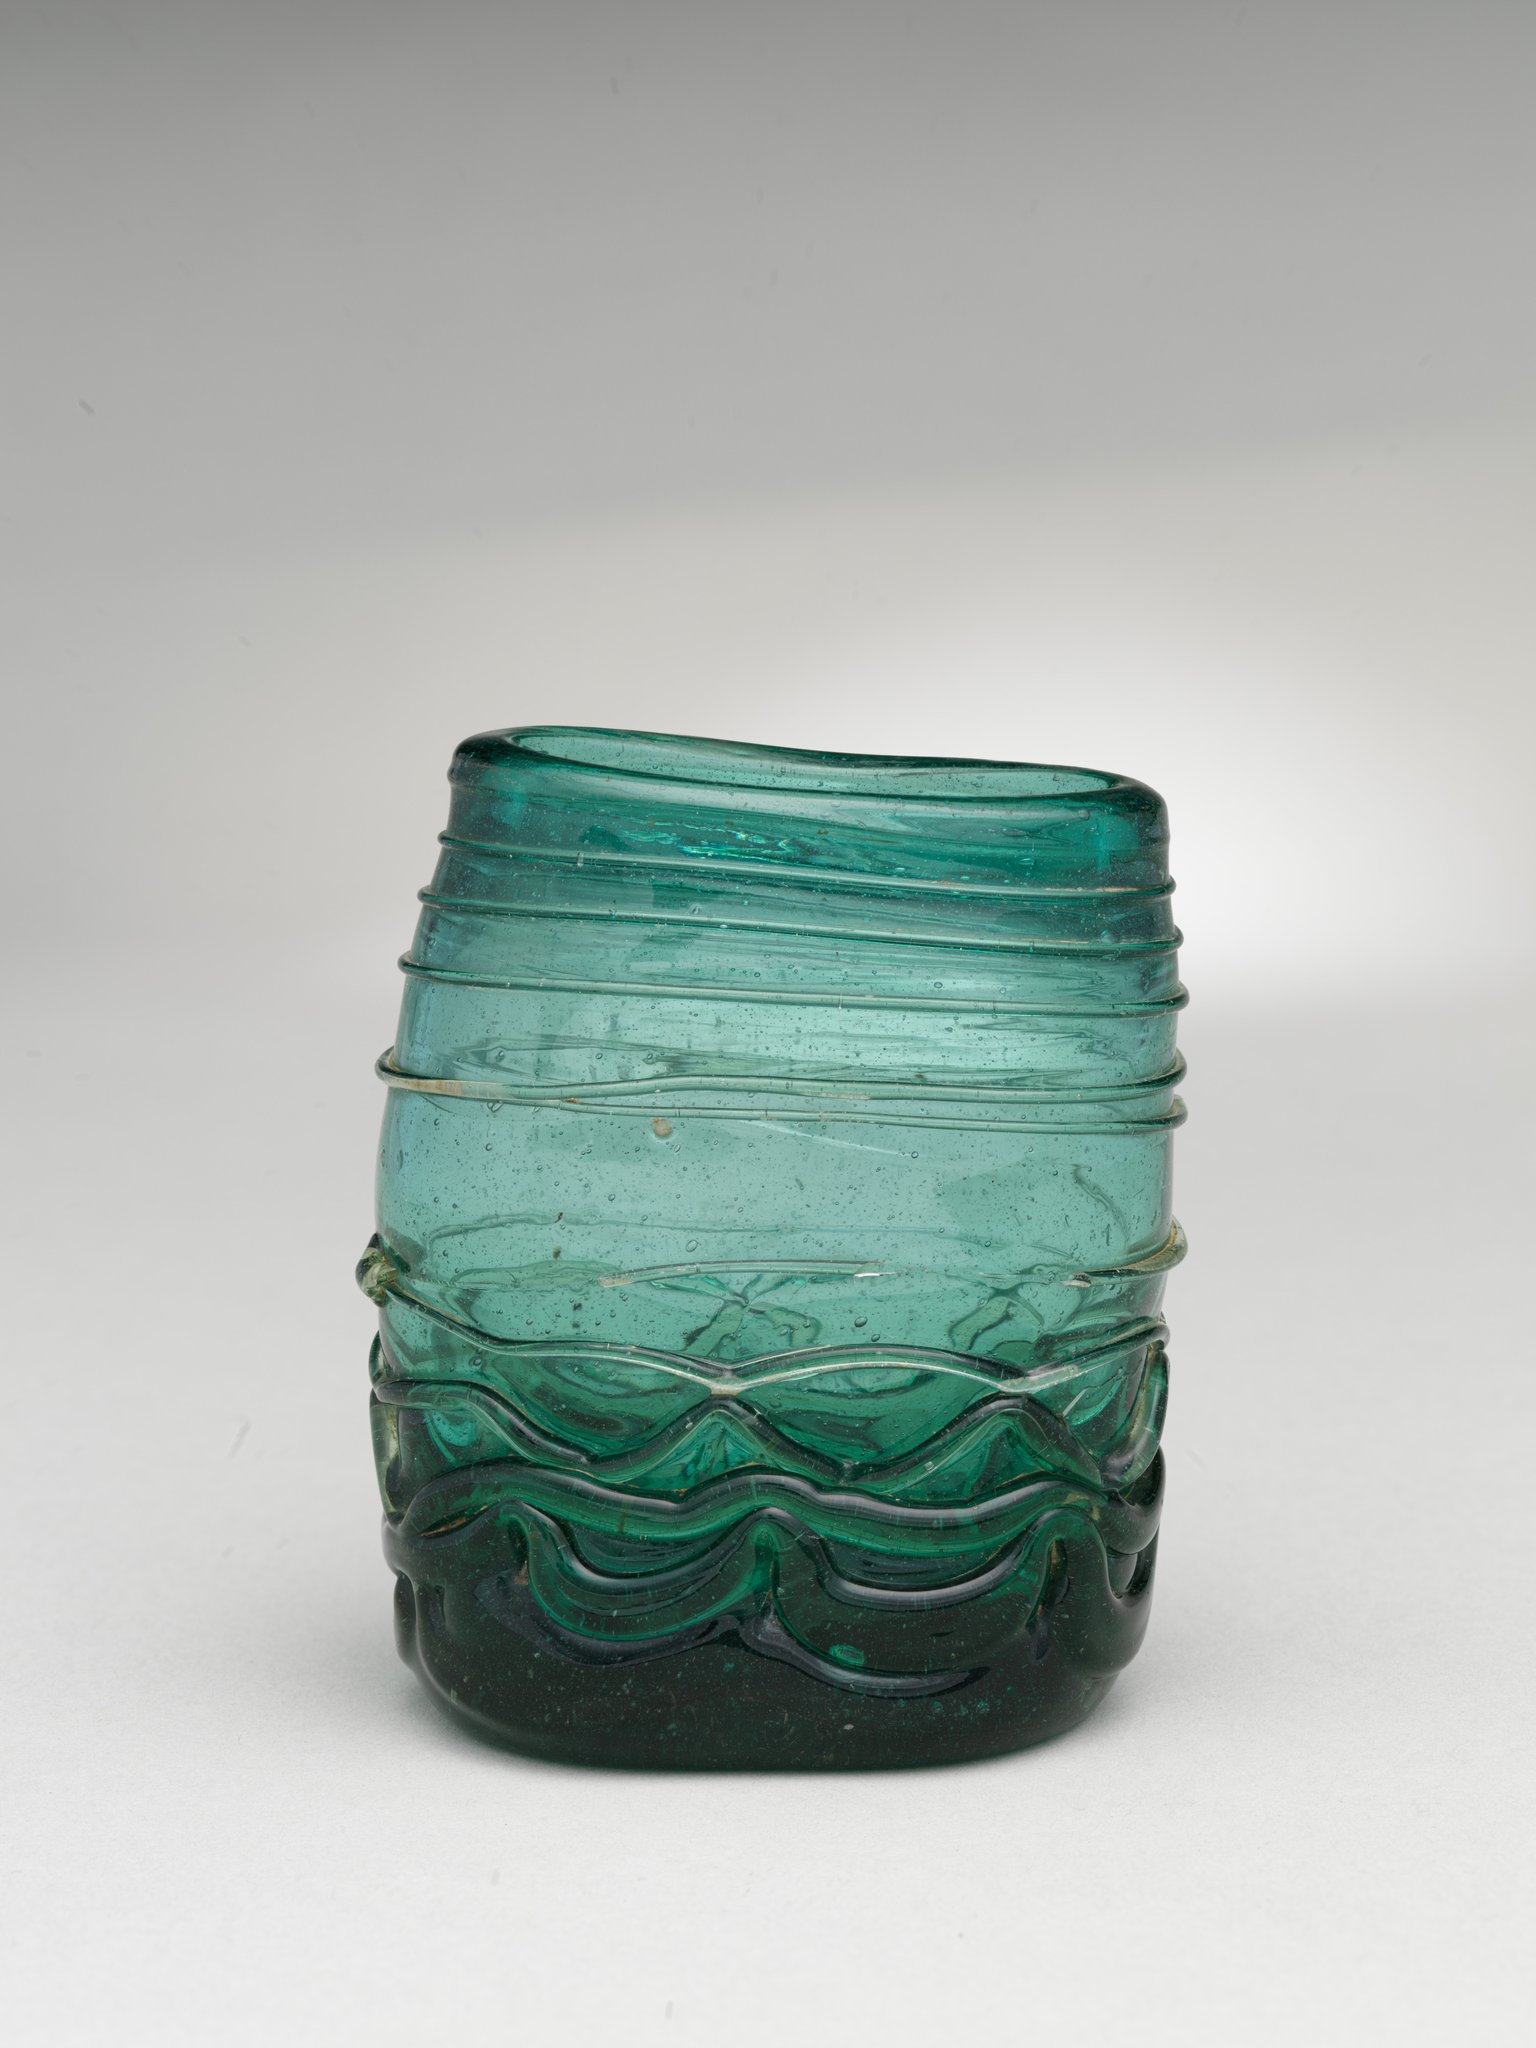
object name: jar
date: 1701-1800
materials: glass